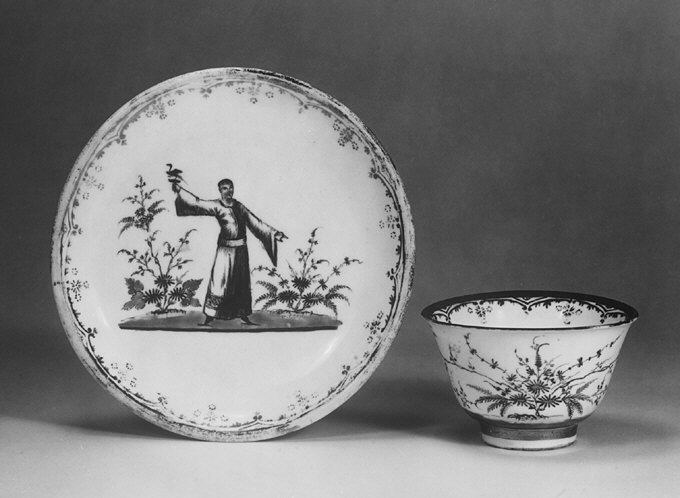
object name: teabowl and saucer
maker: meissen manufactory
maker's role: manufactory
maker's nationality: german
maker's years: 1710-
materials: hard paste porcelain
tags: men